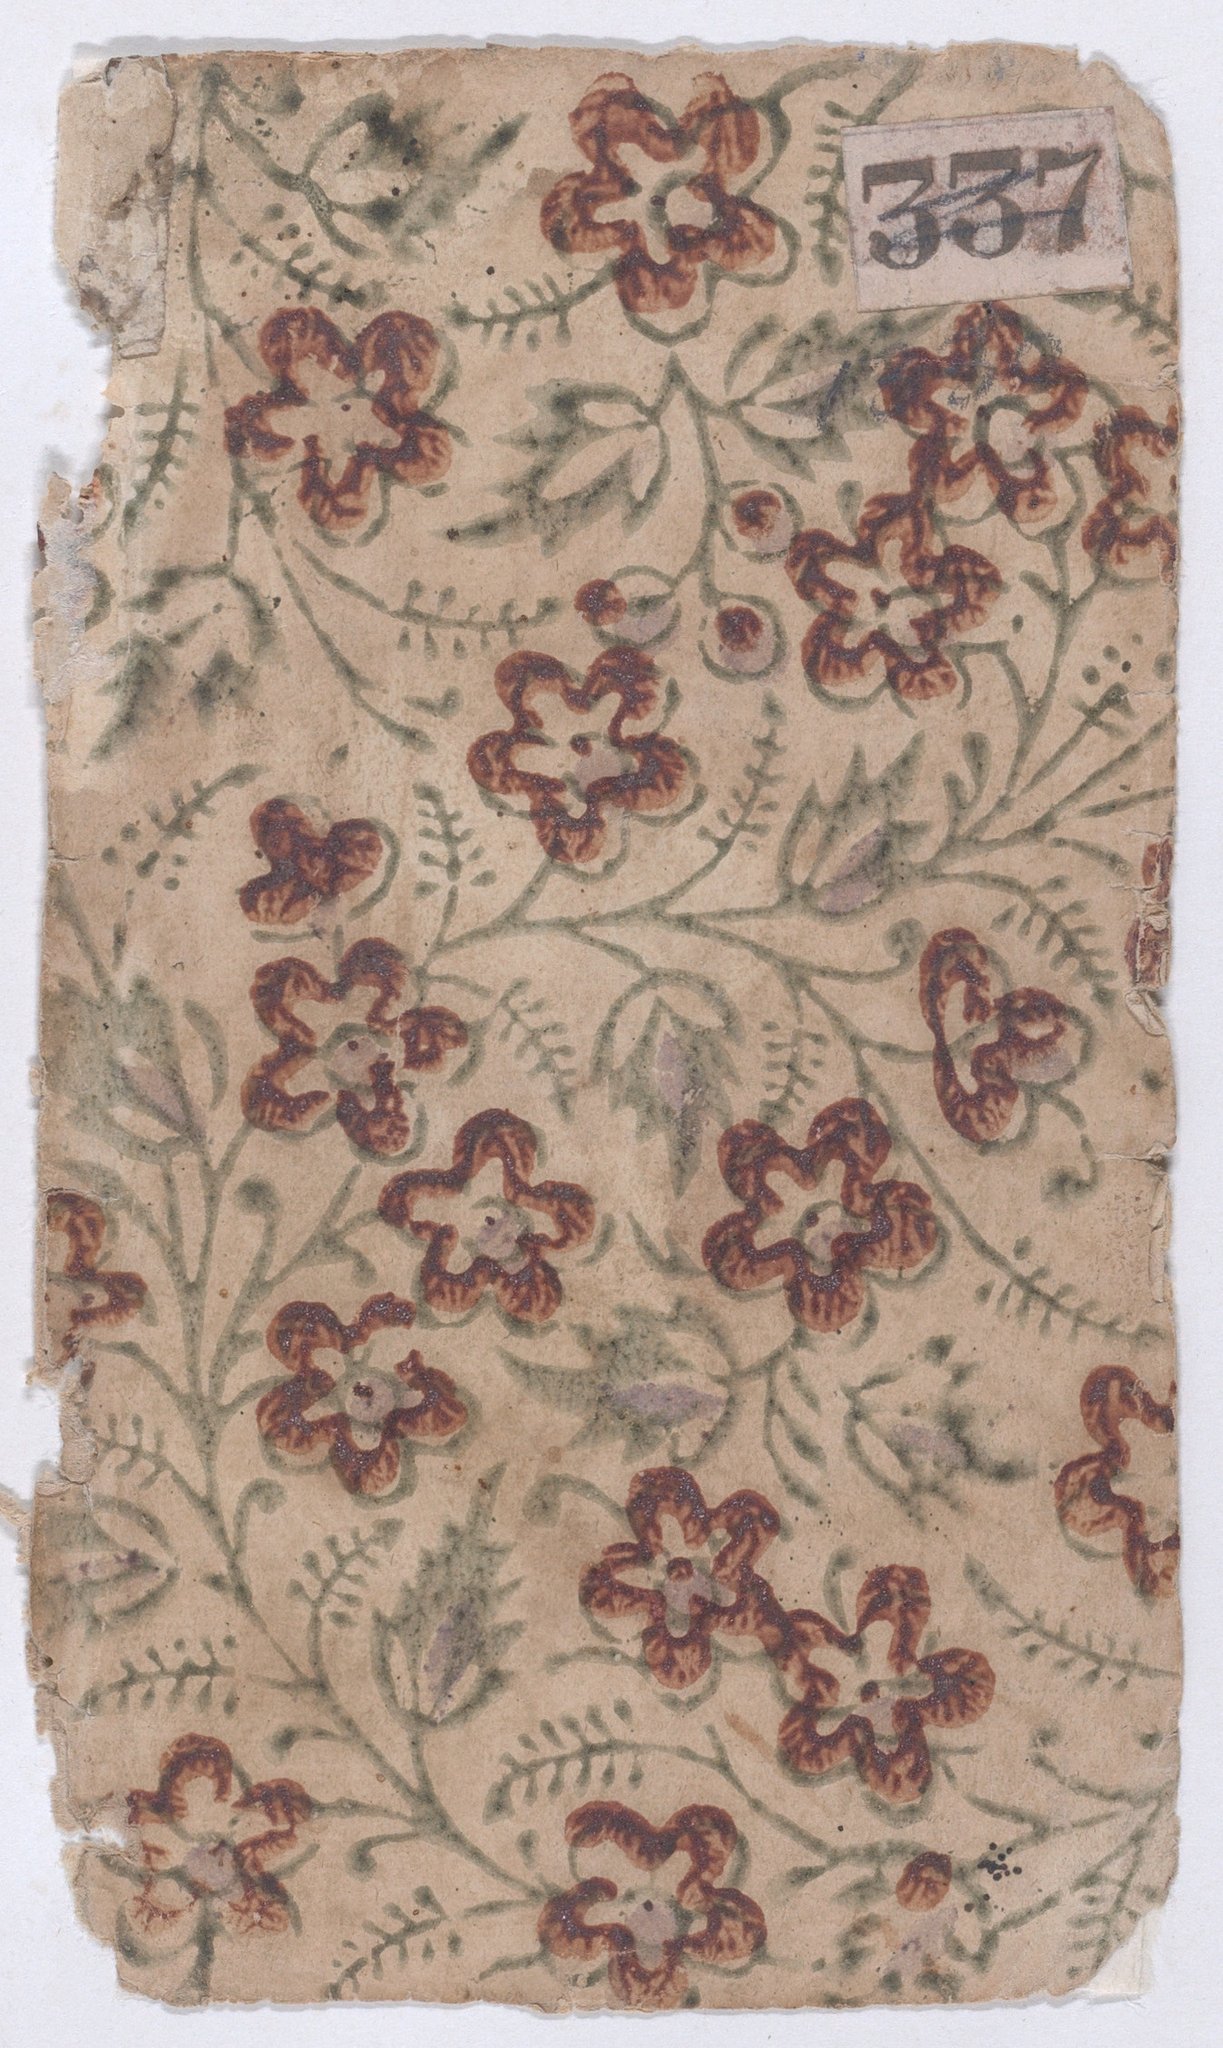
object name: print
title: Sheet with an overall floral pattern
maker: Anonymous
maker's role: artist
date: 1801-1900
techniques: relief print